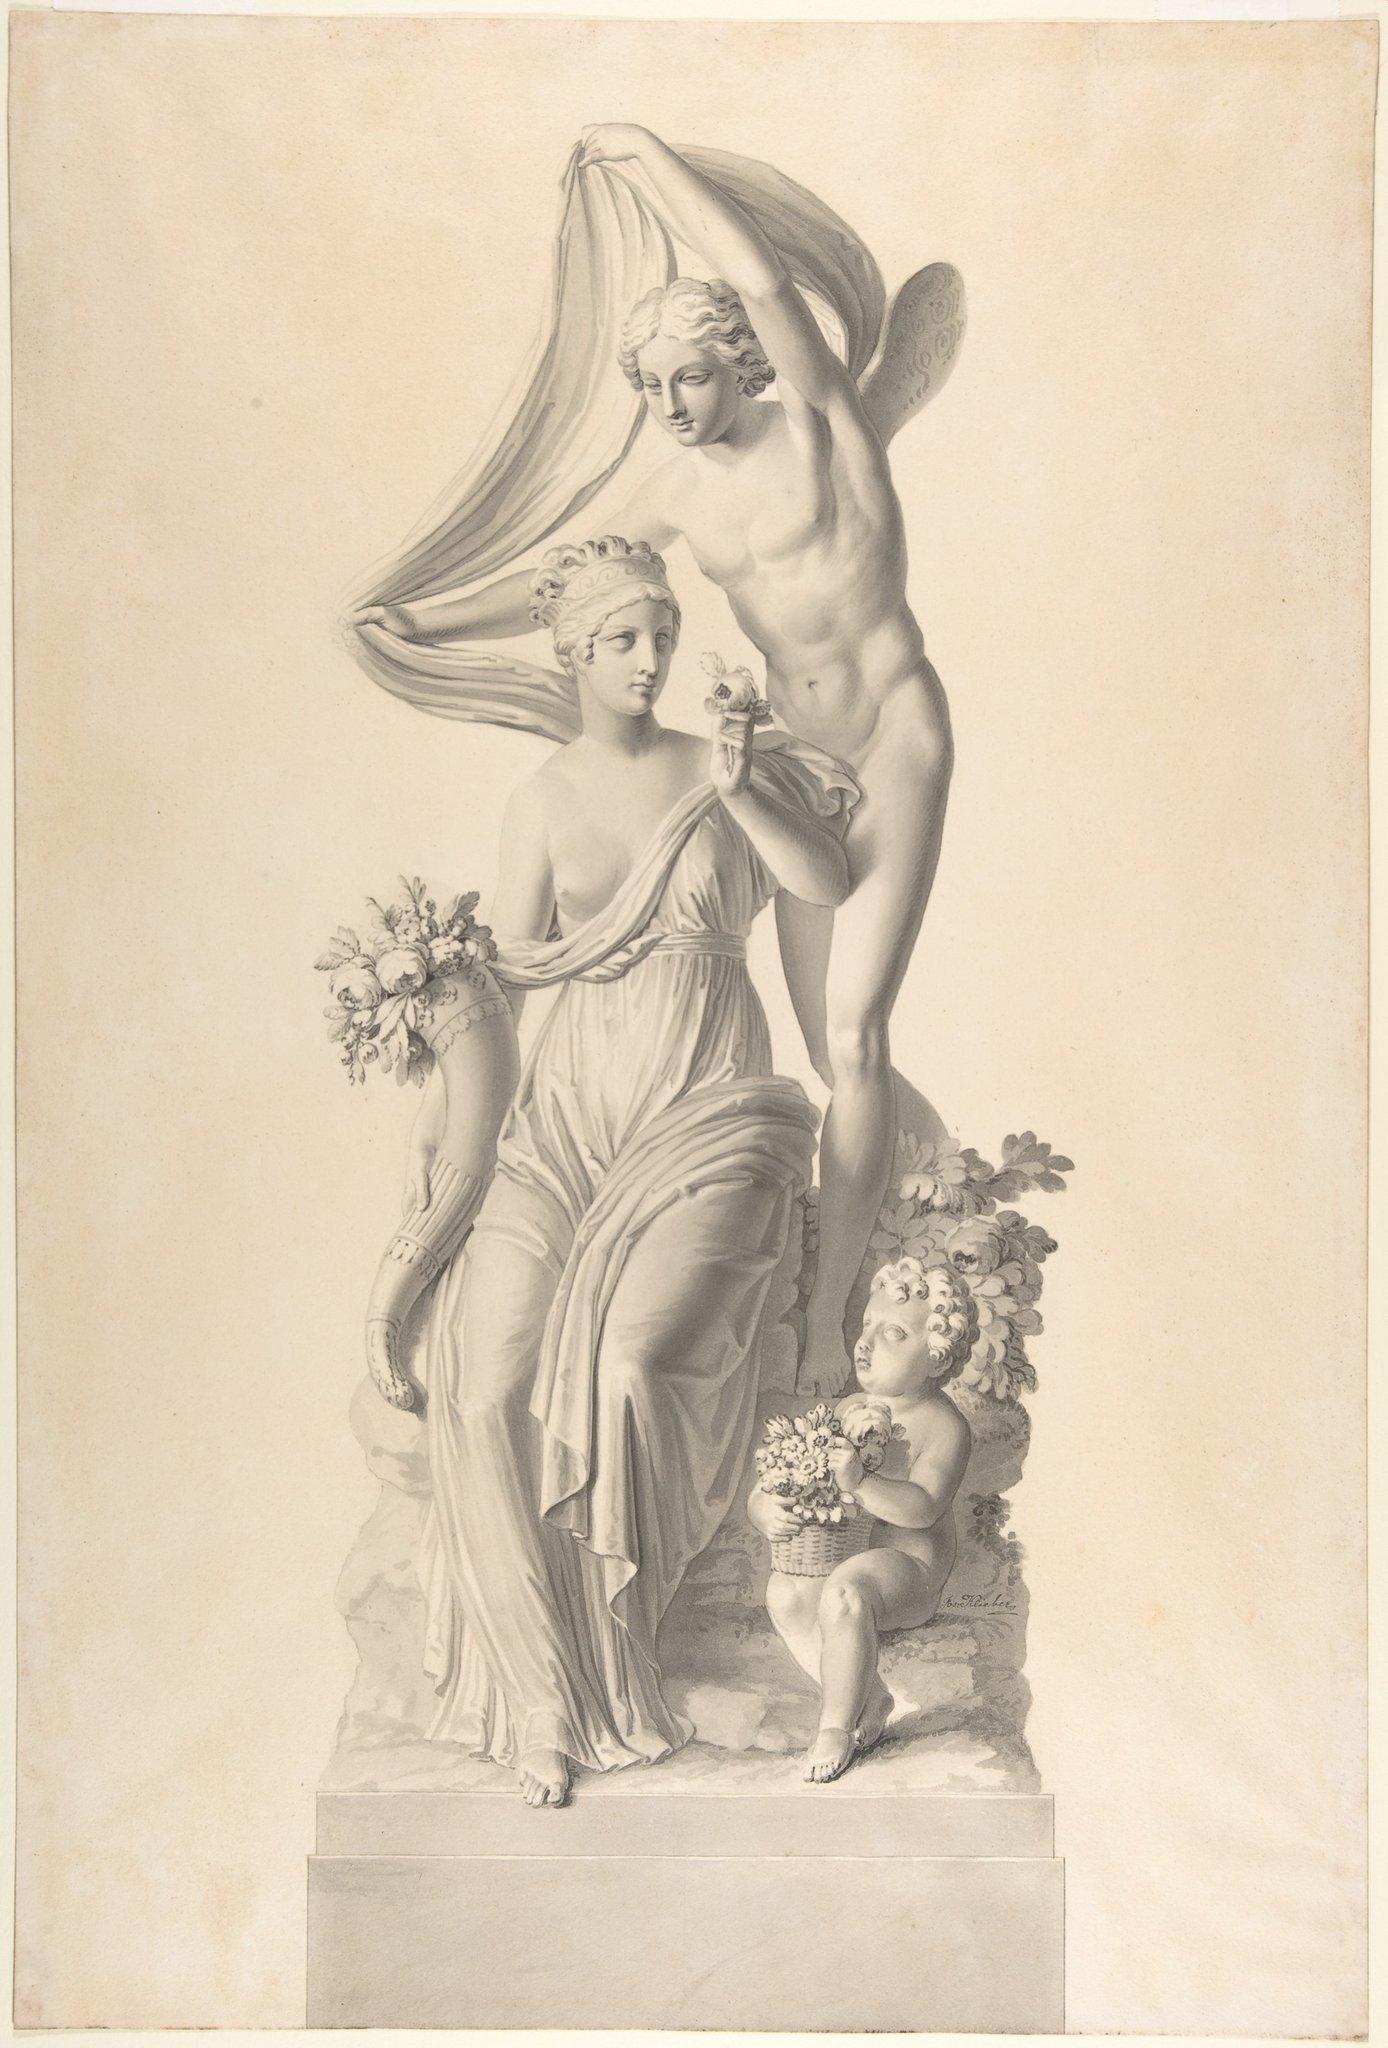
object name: drawing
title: Flora and Zephyr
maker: josef klieber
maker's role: artist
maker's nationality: austrian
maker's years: 1773-1850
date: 1767-1900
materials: ink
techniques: pen, wash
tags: children,male nudes,female nudes,cornucopia